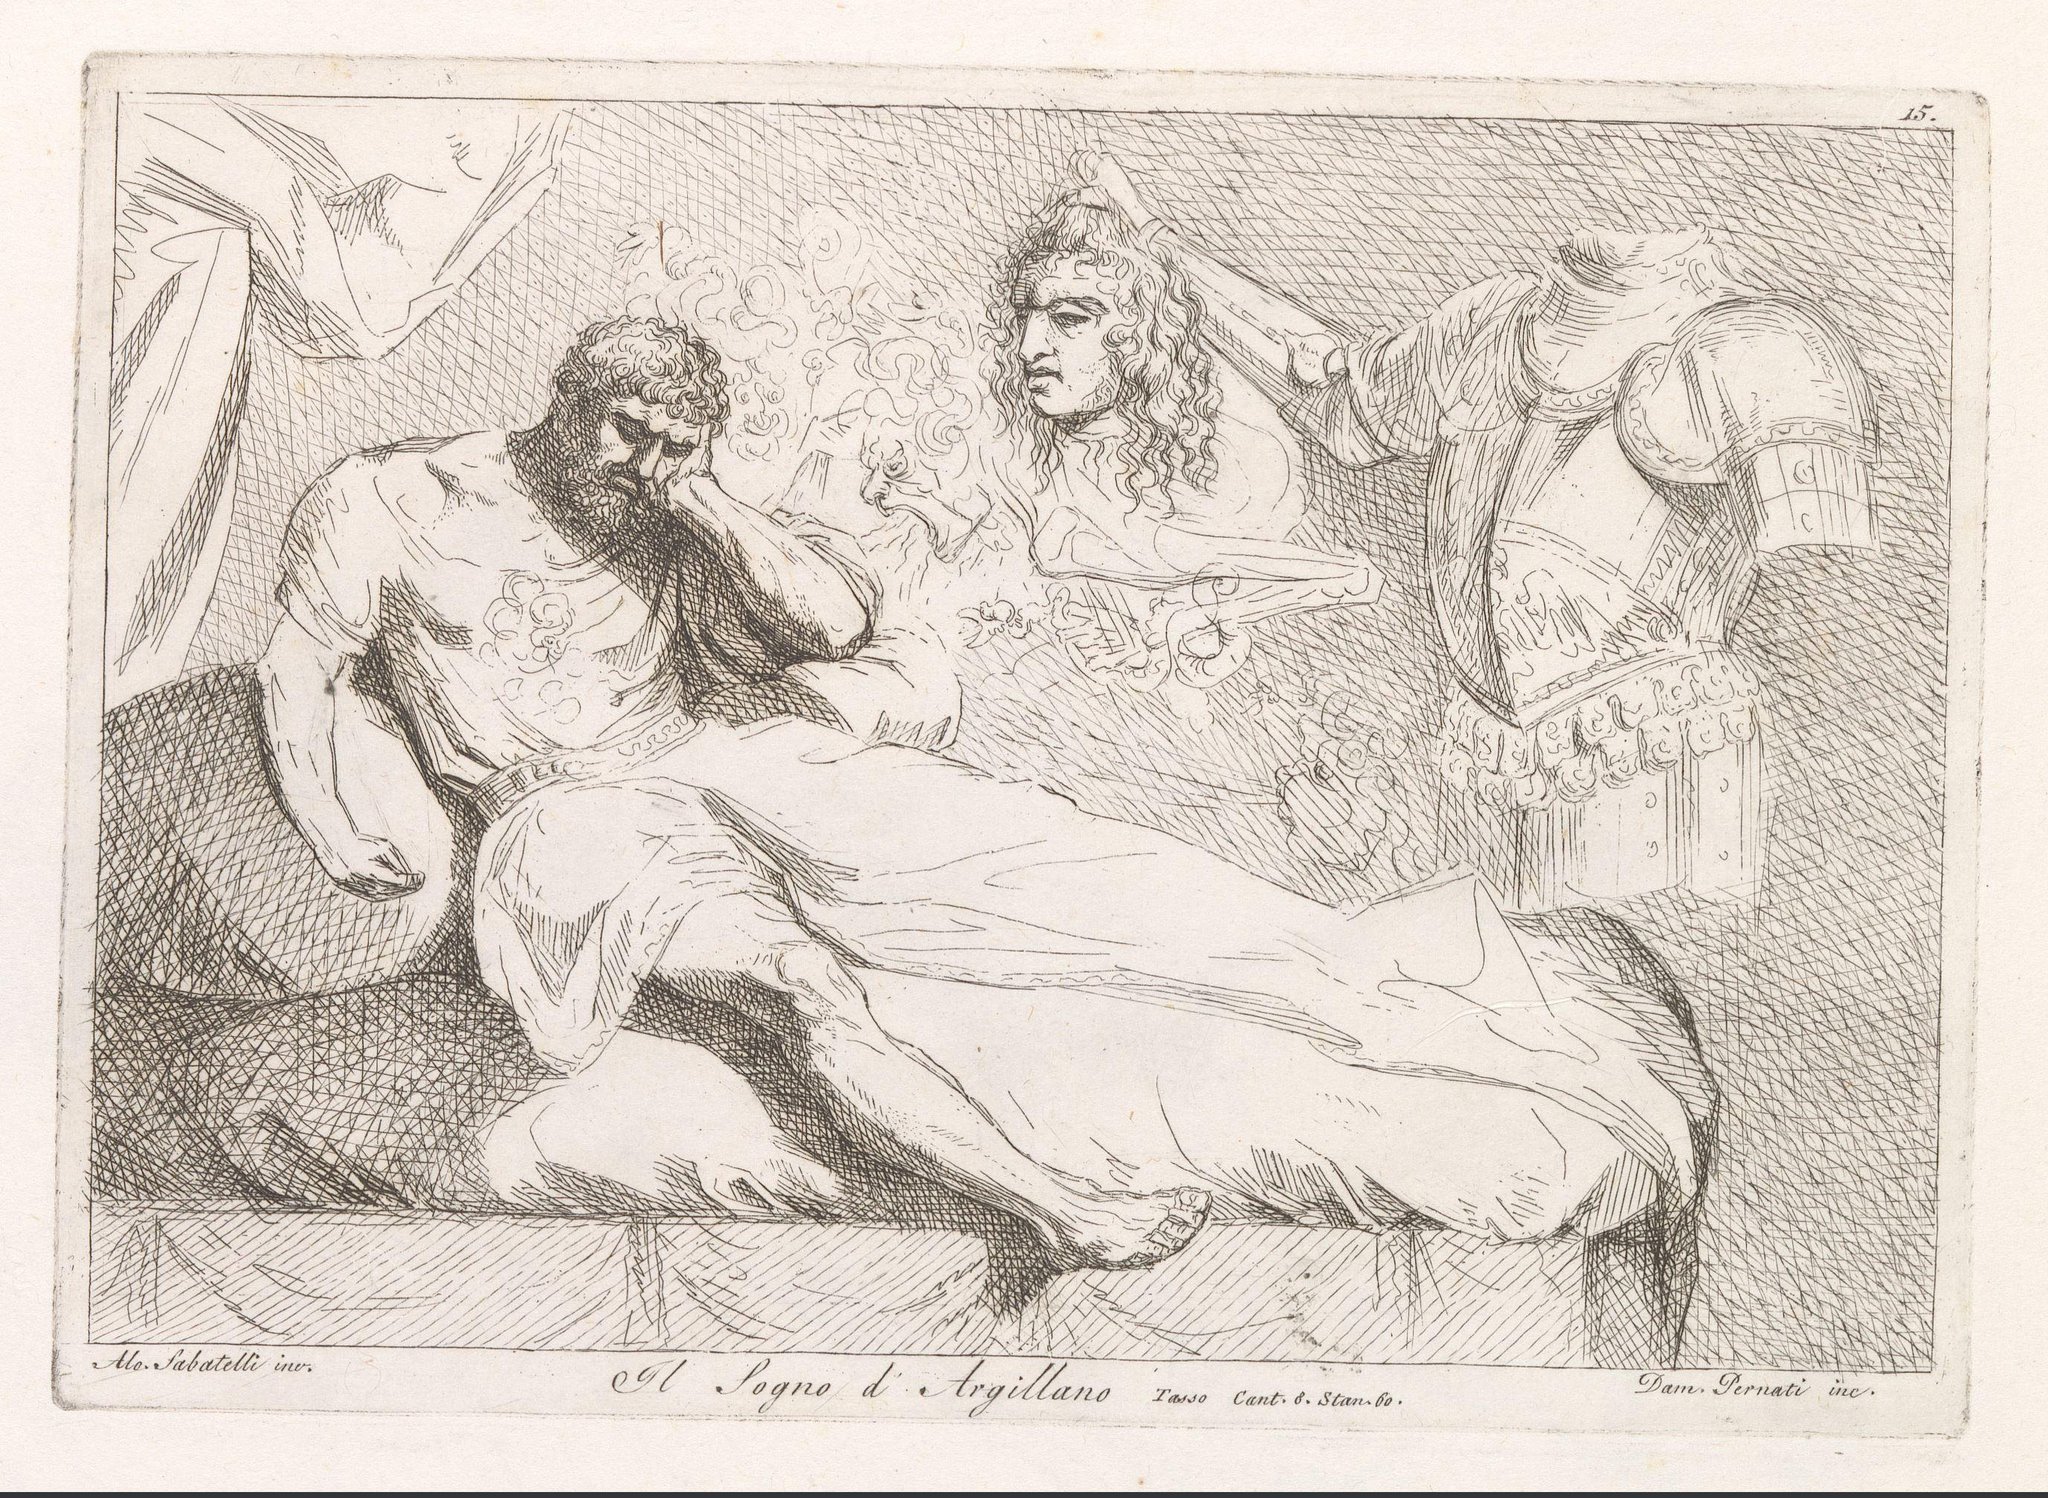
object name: print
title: Il Sogno d'Argillano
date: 1804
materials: paper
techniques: etching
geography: italy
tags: dream, (scenes from) specific works of literature: tasso, gerusalemme liberata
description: Droom van Argillano, uit Tasso's 'La Gerusalemme liberata'. Prent nr. 15 op blad 9 in het album 'Raccolta di Soggetti Pittorici', een prentalbum met 42 genummerde etsen op 28 pagina's van Luigi Sabatelli (I) zelf en van leerlingen naar diens ontwerp.